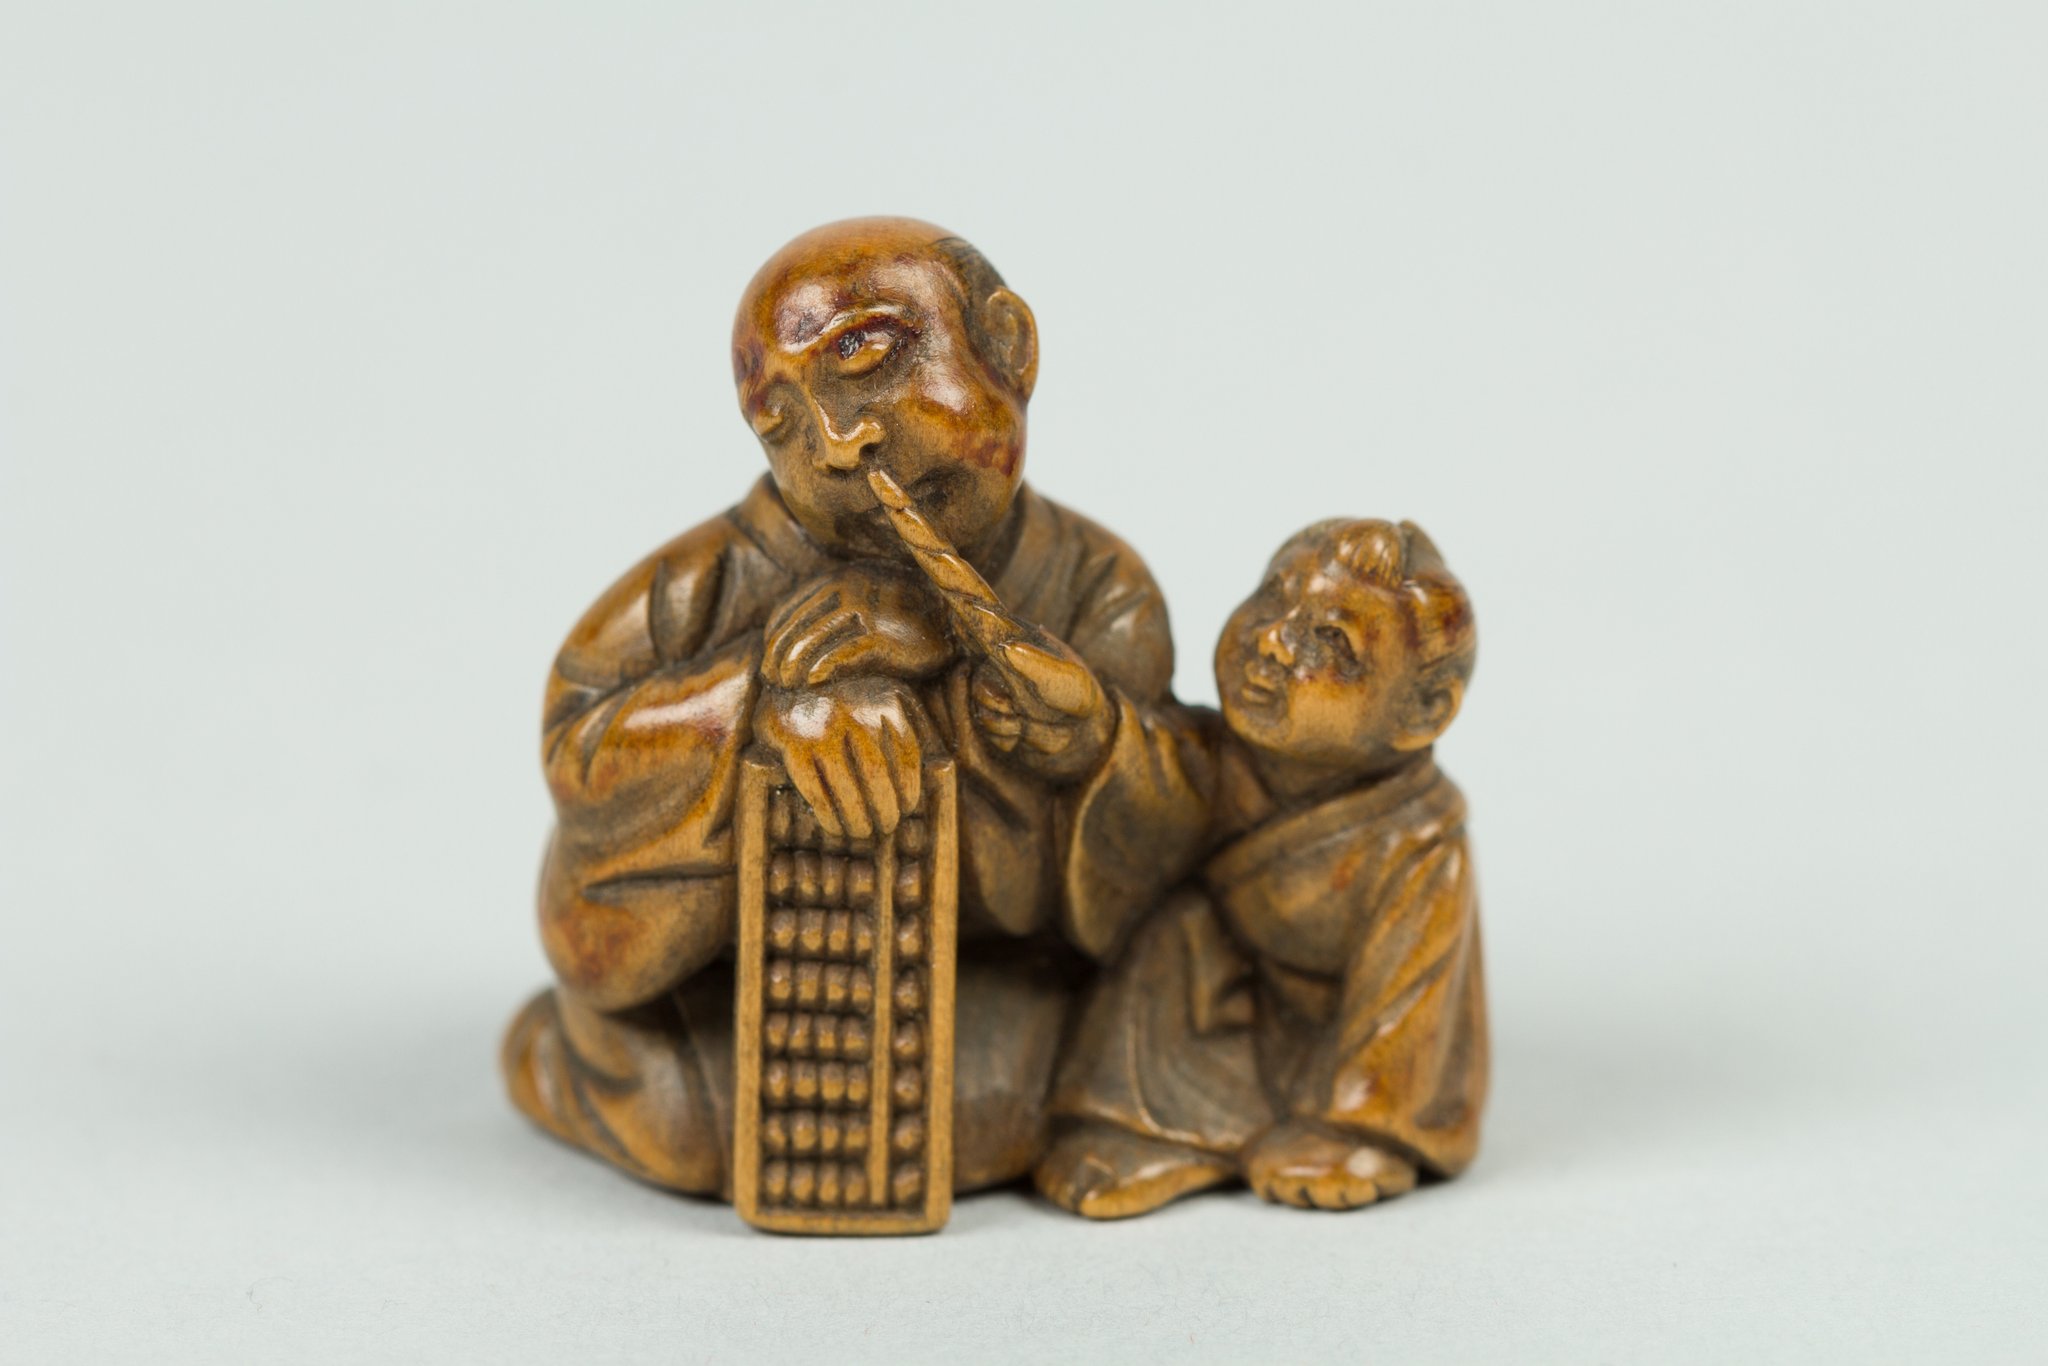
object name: netsuke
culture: japanese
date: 1701-1800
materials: wood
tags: children,men